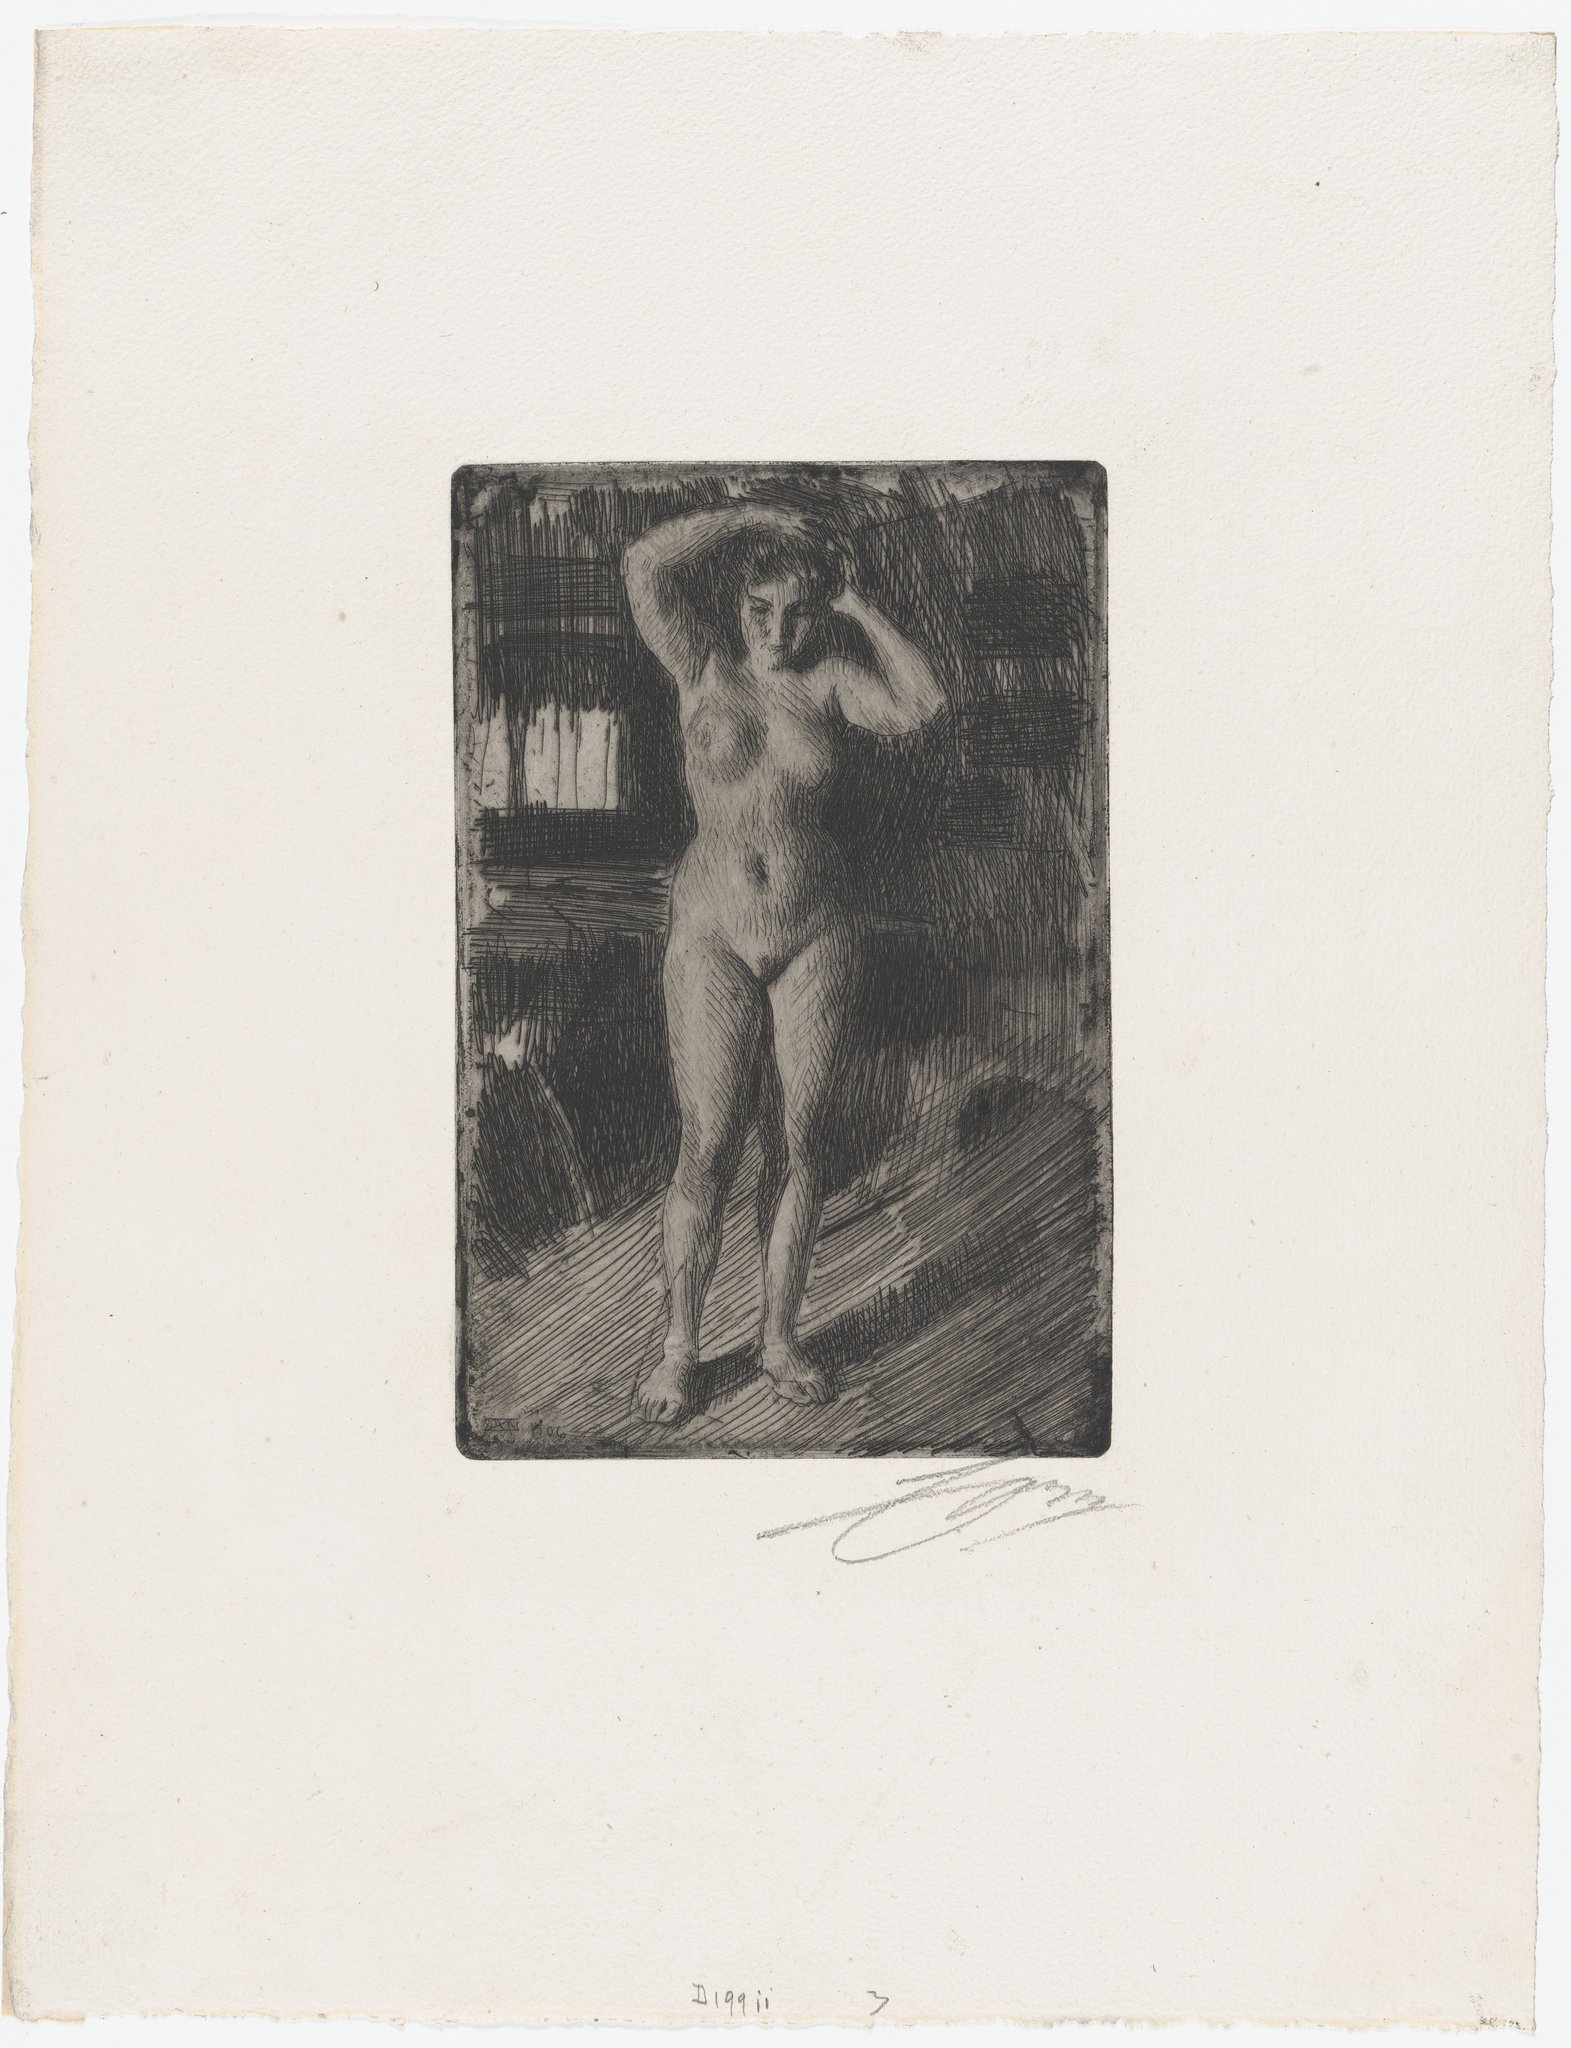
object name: print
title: Anna Doing Her Hair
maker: anders zorn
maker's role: artist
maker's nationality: swedish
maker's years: 1860-1920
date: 1906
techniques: etching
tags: hair,female nudes